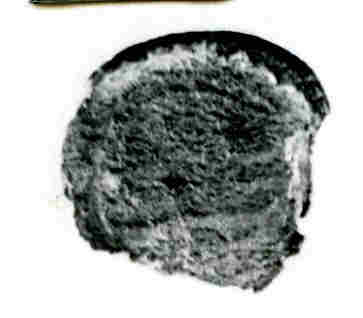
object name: coin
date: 701-900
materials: copper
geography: iran